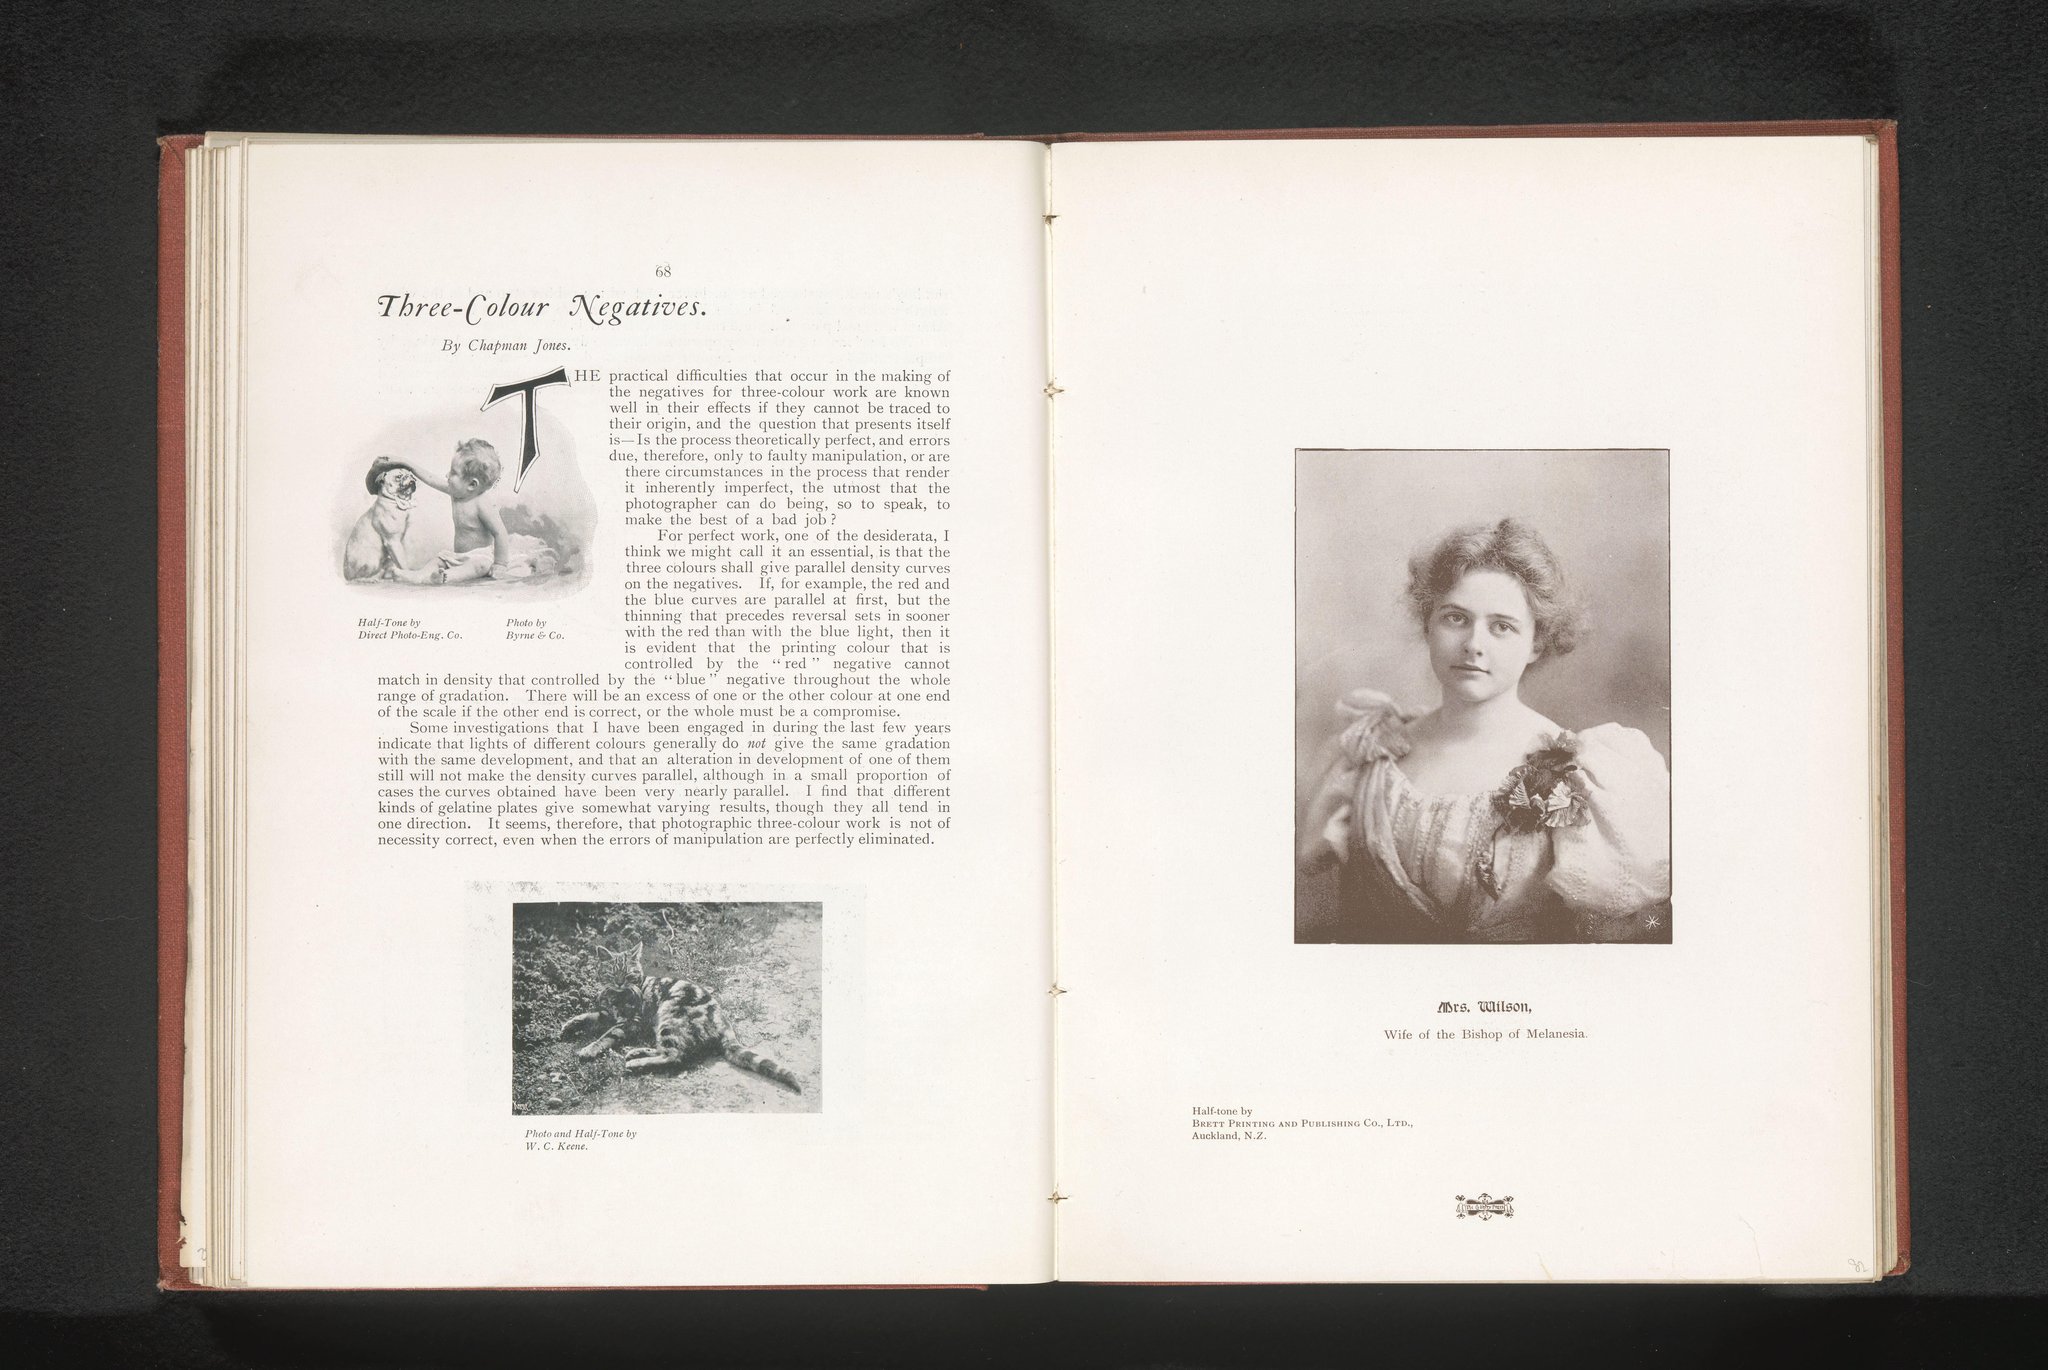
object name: page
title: Portret van een onbekende vrouw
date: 1895-1900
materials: paper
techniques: autotype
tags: historical persons - bb - woman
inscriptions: inscription: ‘Wife of the Bishop of Melanesia.’